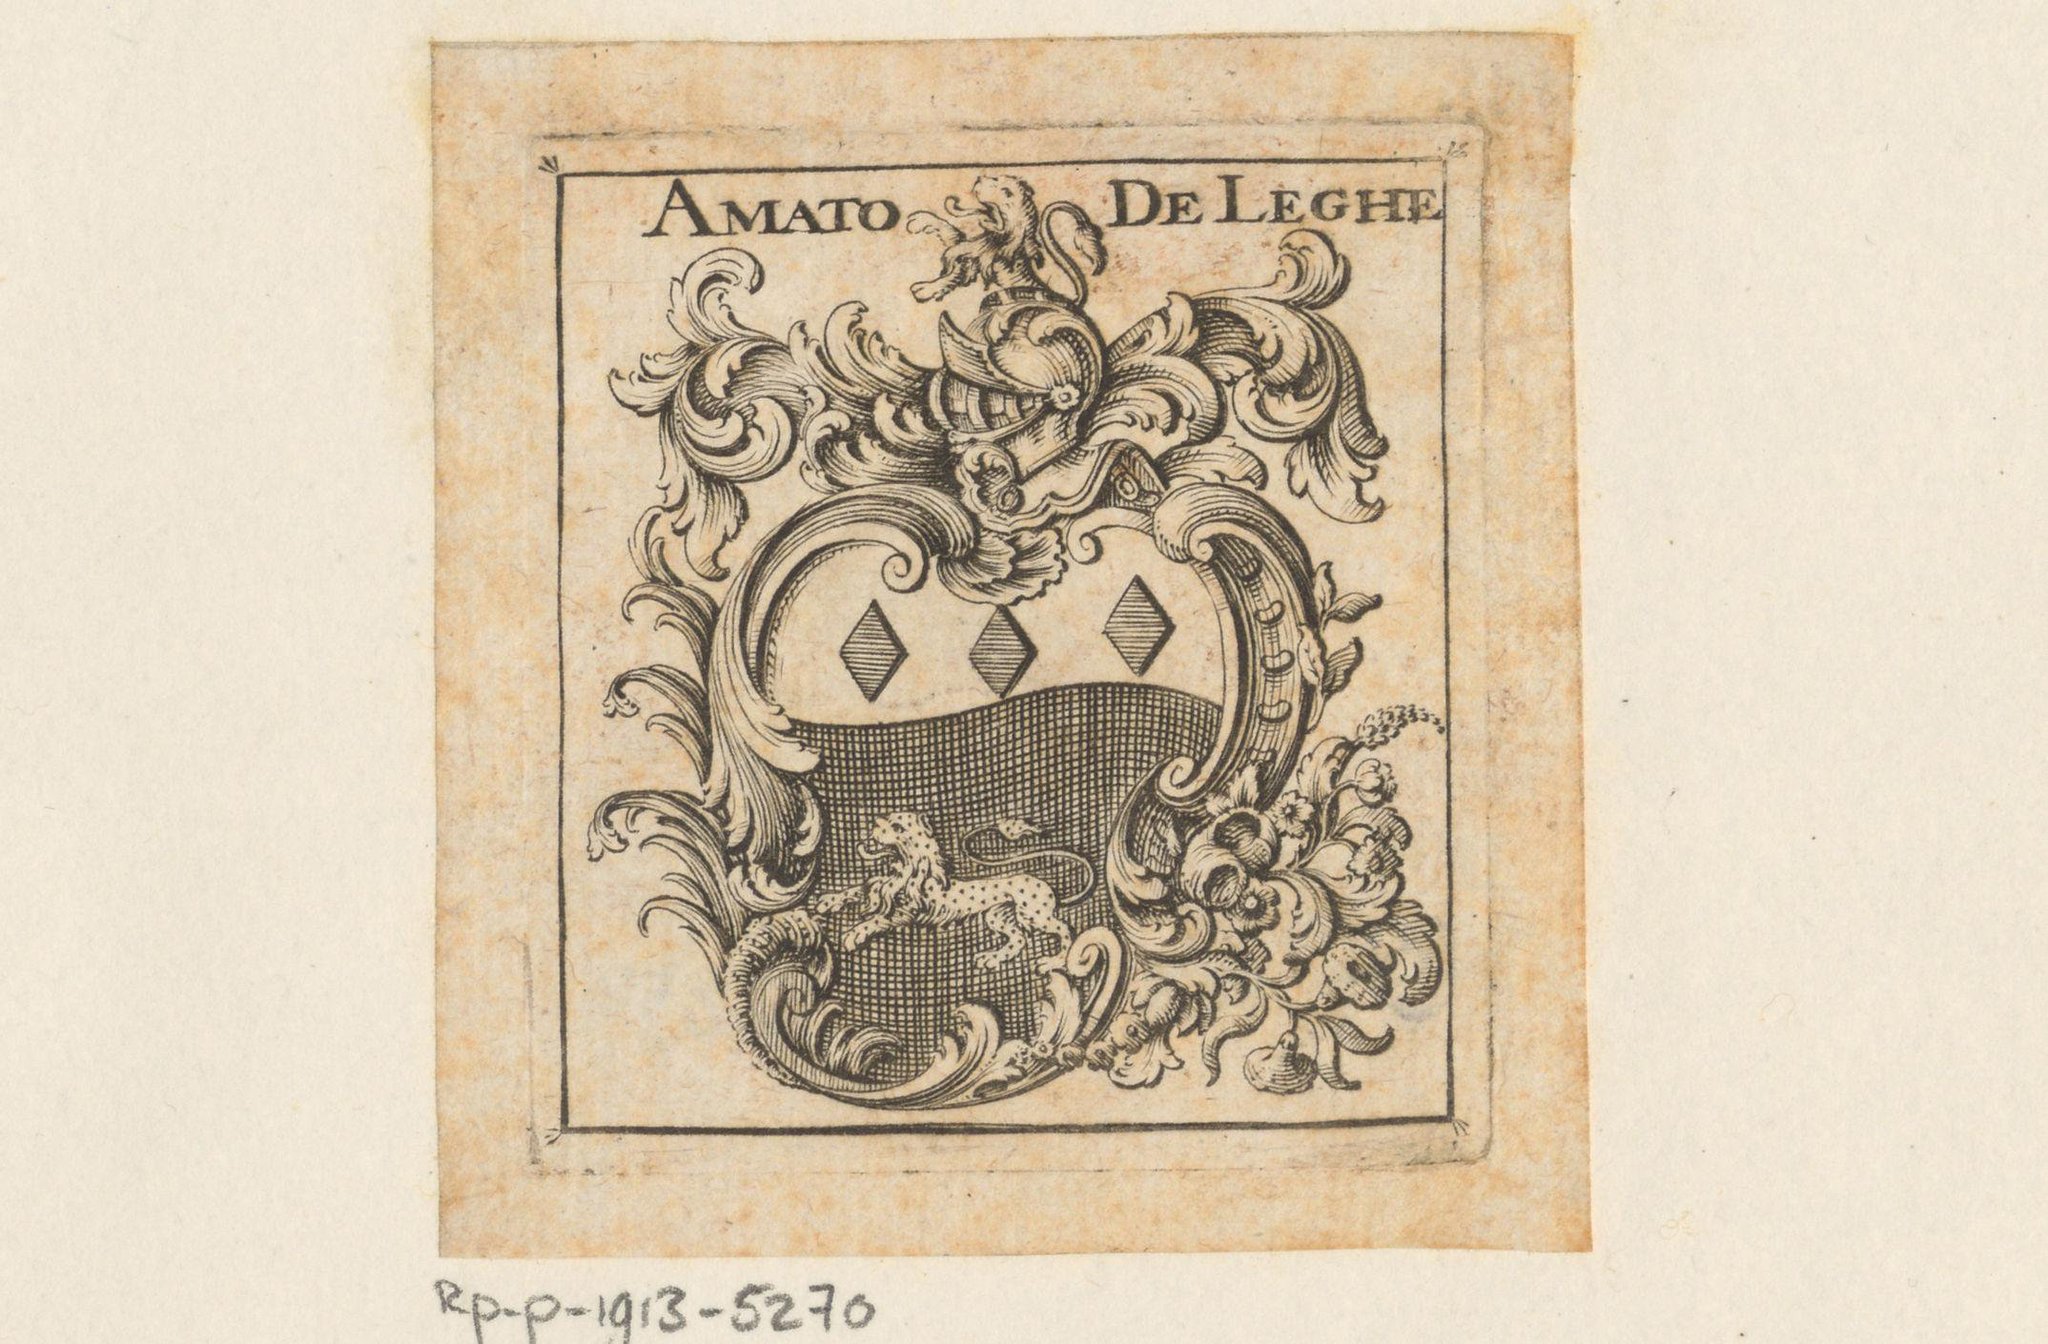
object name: bookplate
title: Ex libris van Amato De Leghe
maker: Anonymous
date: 1750-1799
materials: paper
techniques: engraving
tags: armorial bearing, heraldry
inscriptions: collector's mark: Lugt 2760, collector's mark: Lugt 2233